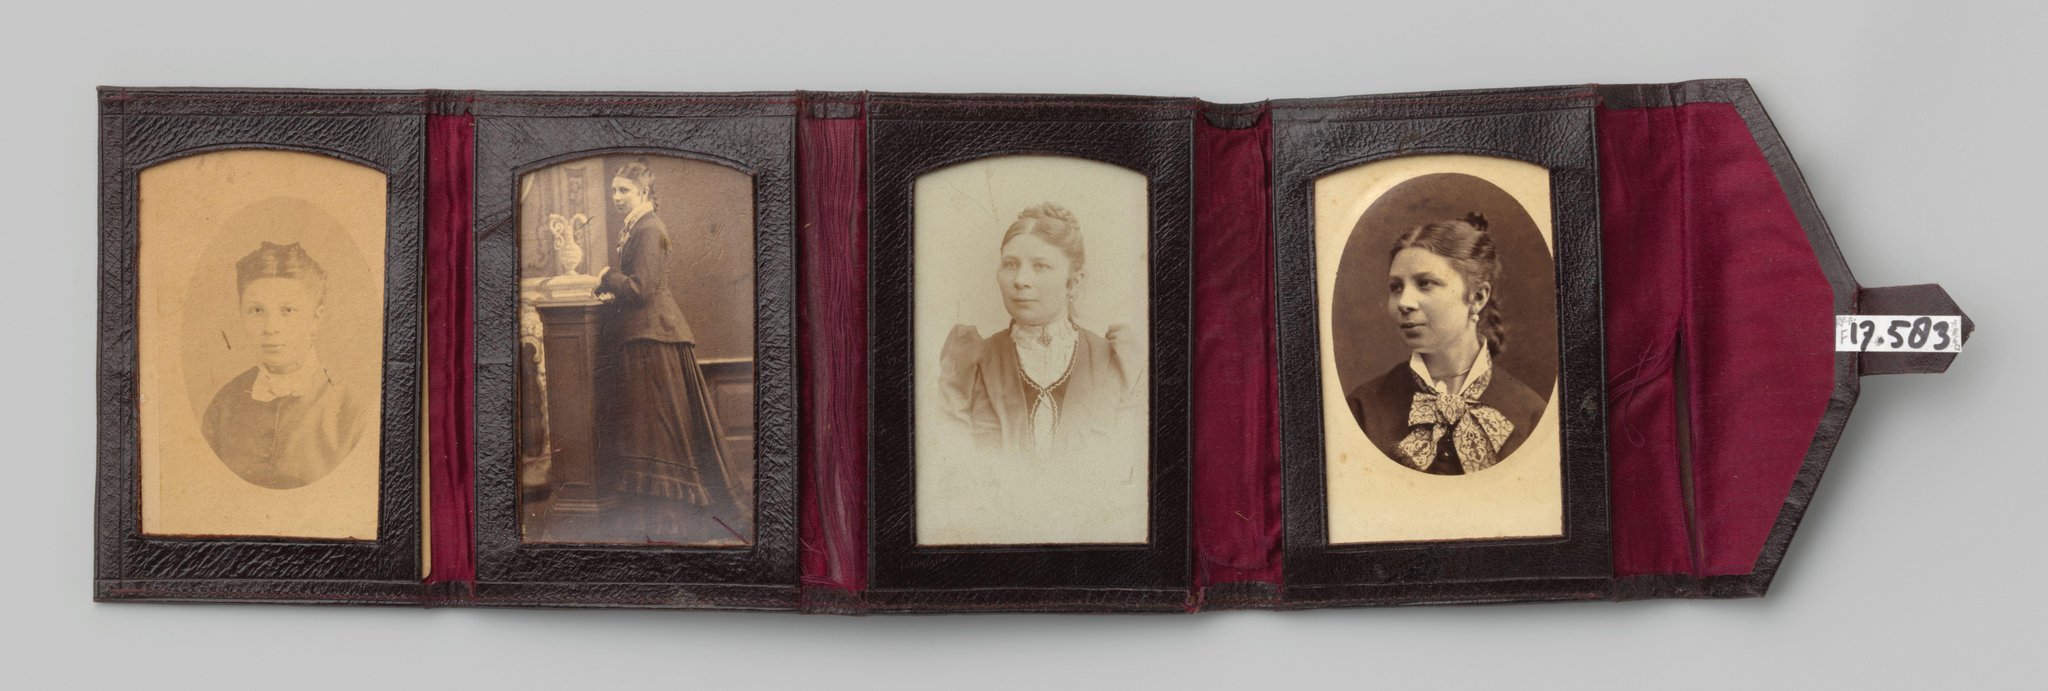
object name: carte de visite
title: Portret van een onbekende vrouw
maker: jacques chits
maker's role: fotograaf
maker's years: 1835-1917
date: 1876-1887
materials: cardboard, paper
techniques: carbon print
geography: haarlem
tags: adult woman, anonymous historical person portrayed, haarlem